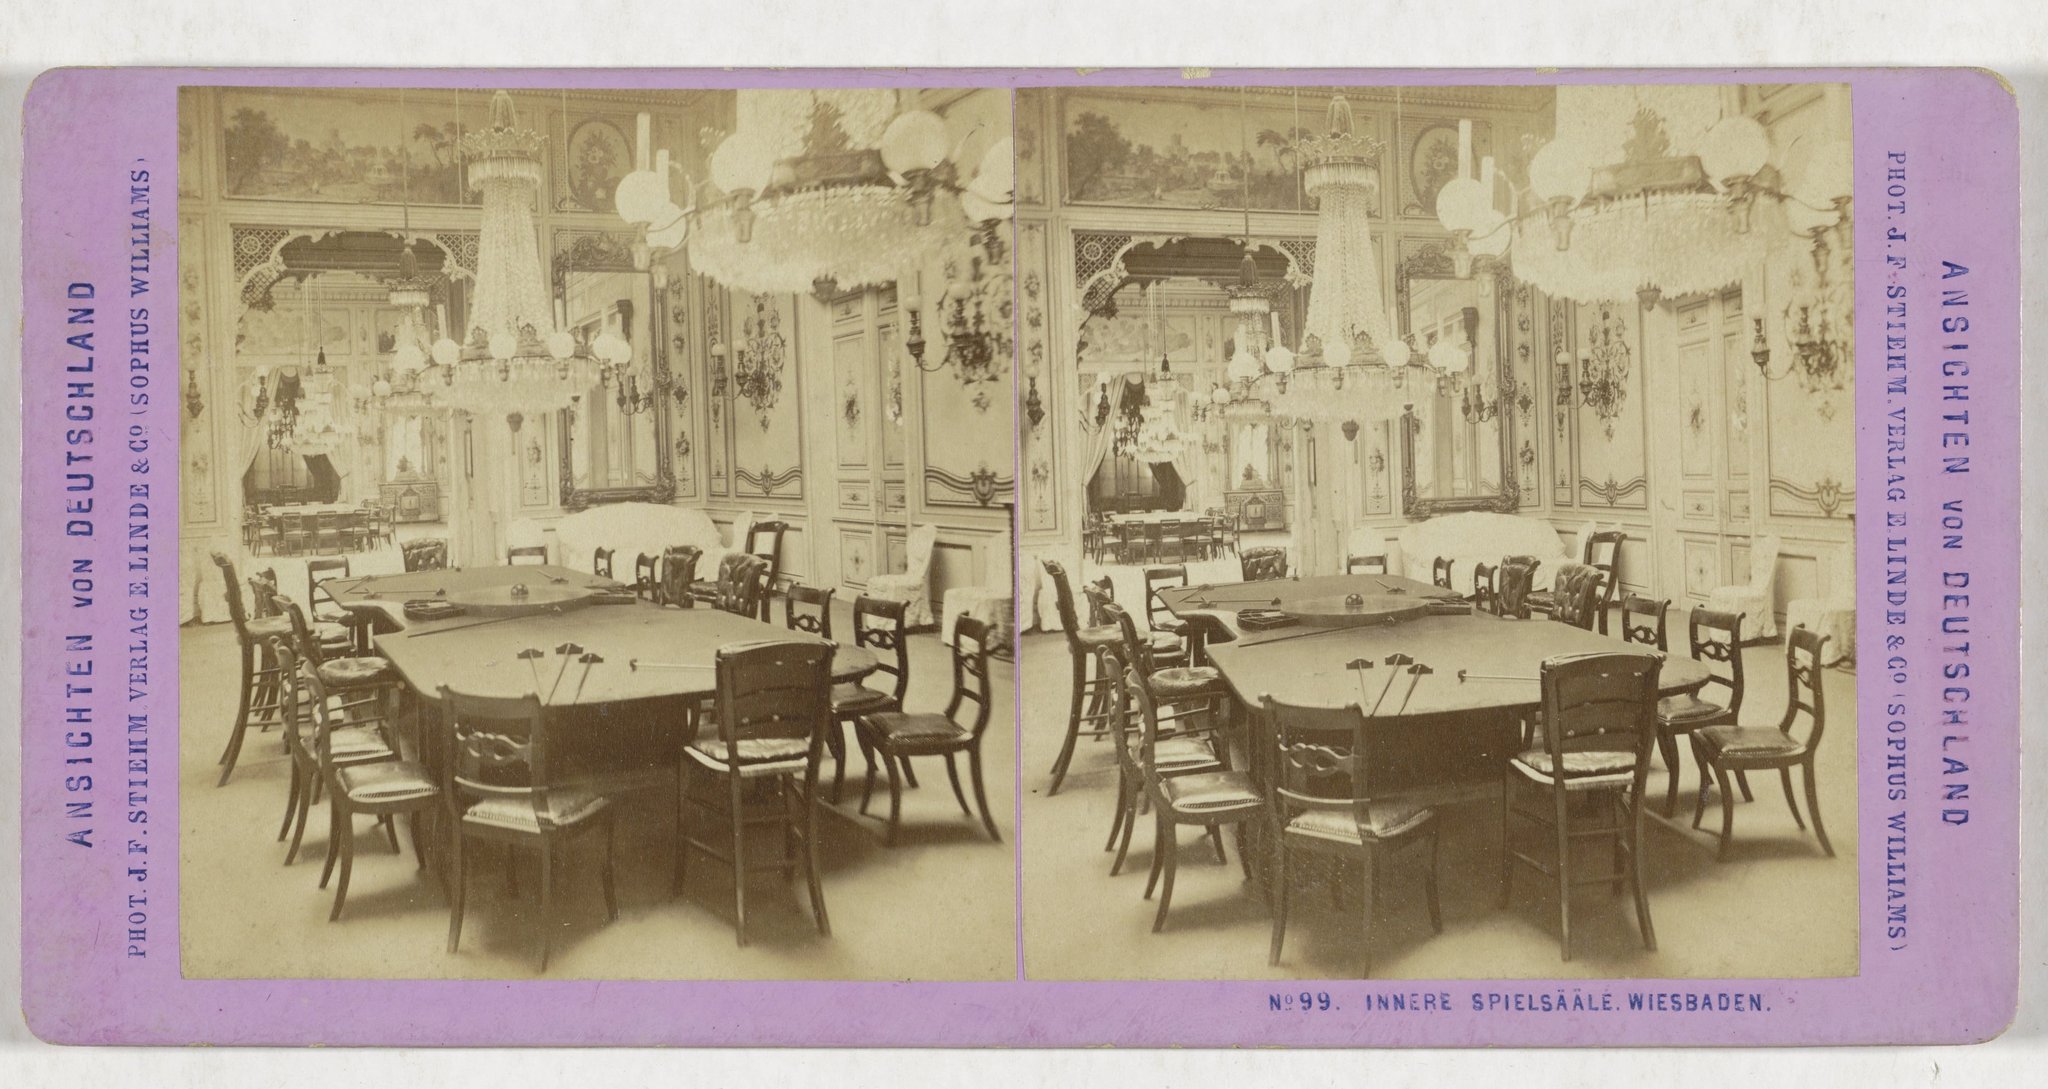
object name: stereograph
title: Casino of de speelzaal, Wiesbaden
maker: johann friedrich stiehm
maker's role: fotograaf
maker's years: 1826-1902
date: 1869-1872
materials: cardboard, paper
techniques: albumen print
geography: wiesbaden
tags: casino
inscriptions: inscription: ‘p 60 [?]’, number: ‘No 99.’, number: ‘No. 92.’